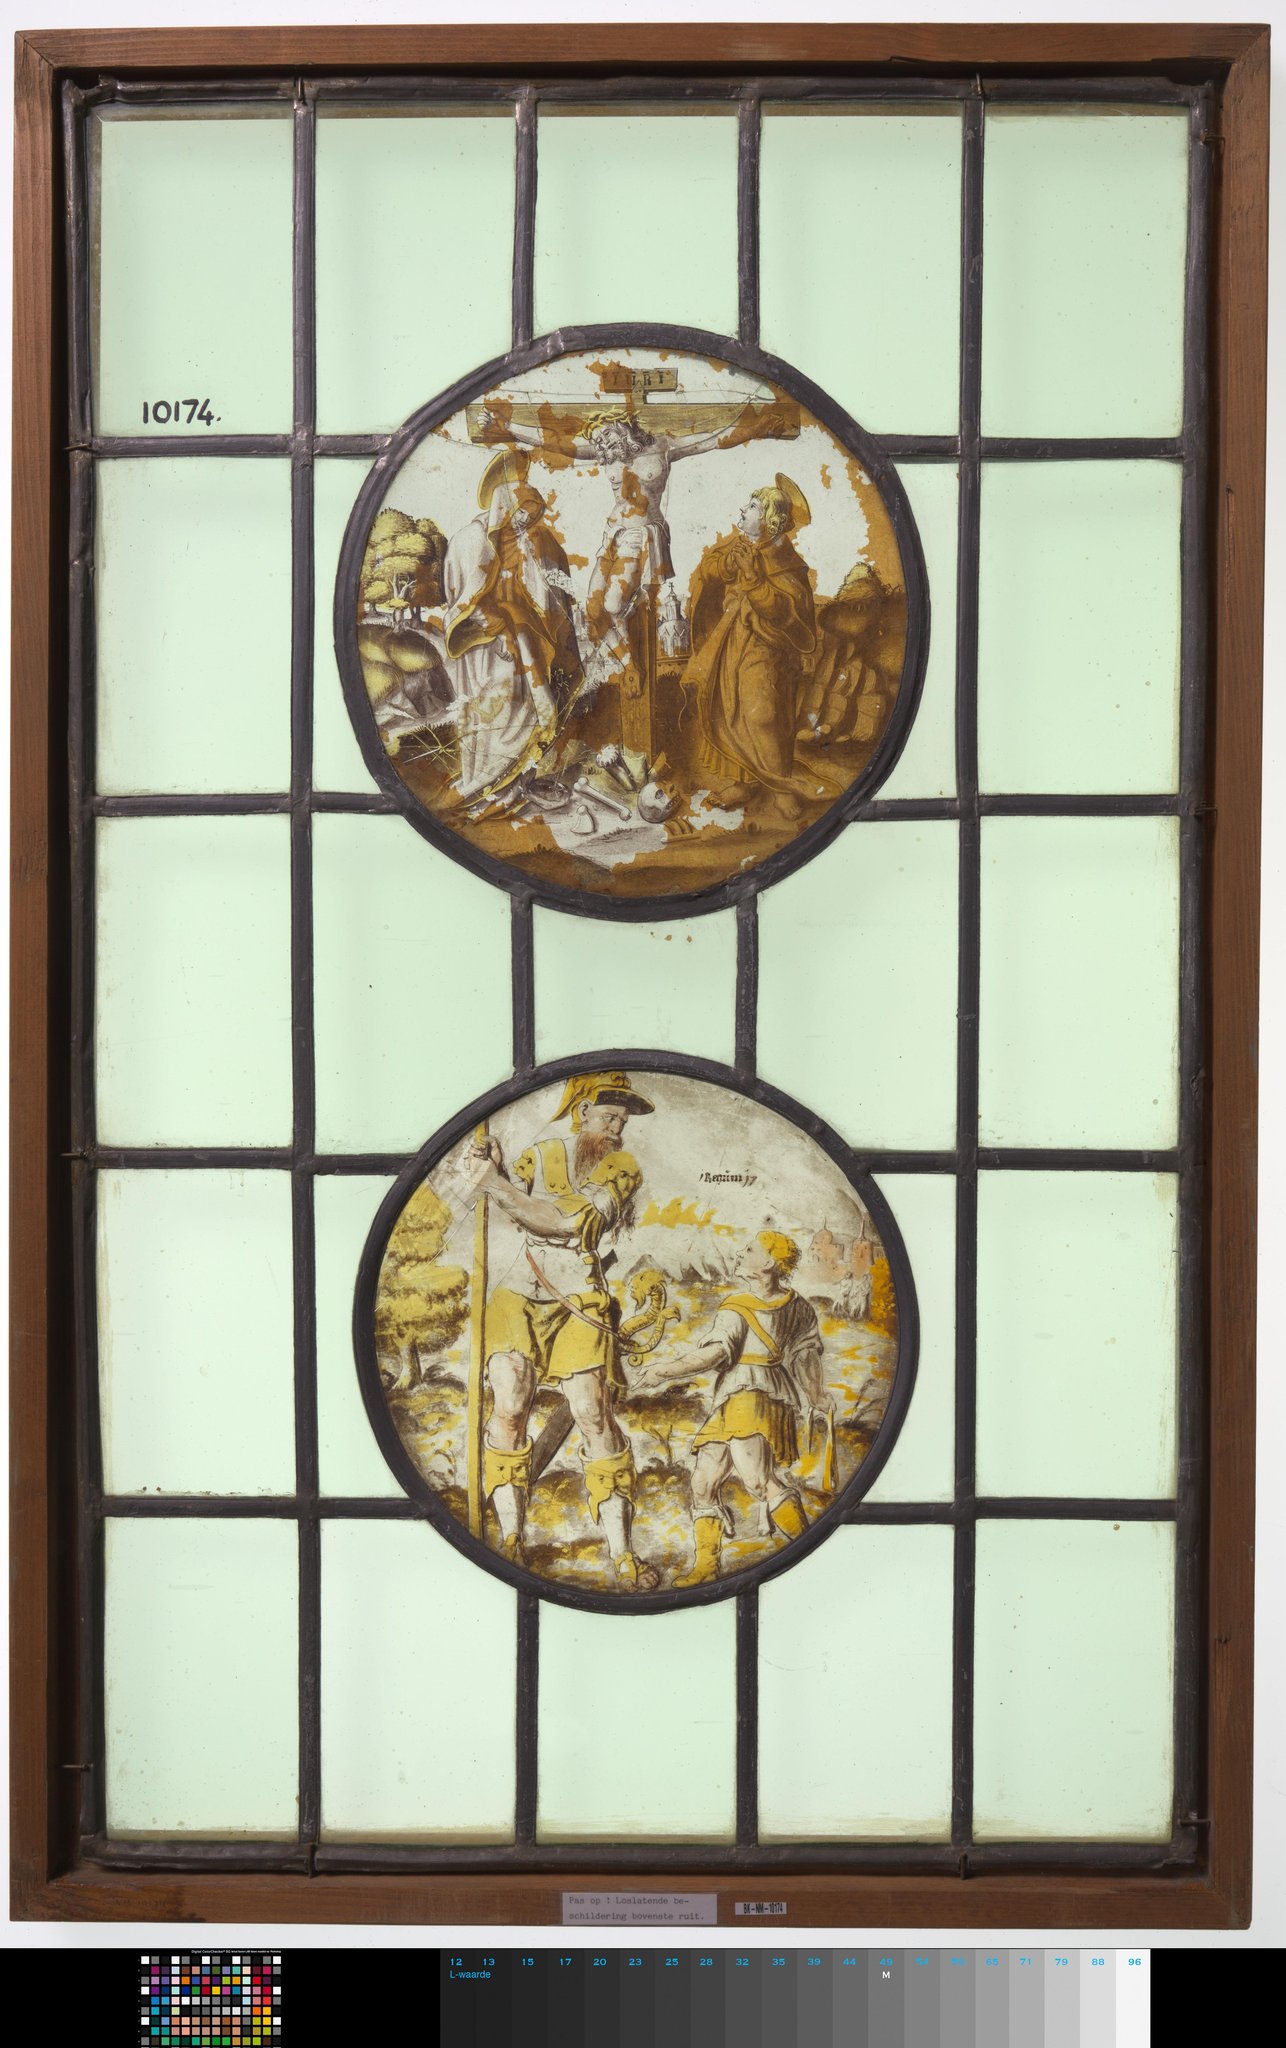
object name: light window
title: Ruit met Christus aan het kruis en David en Goliath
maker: Anonymous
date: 1525-1550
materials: glass, lead, pigment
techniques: leading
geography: antwerp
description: Twee ronde ruiten met Christus aan het kruis en David en Goliath.